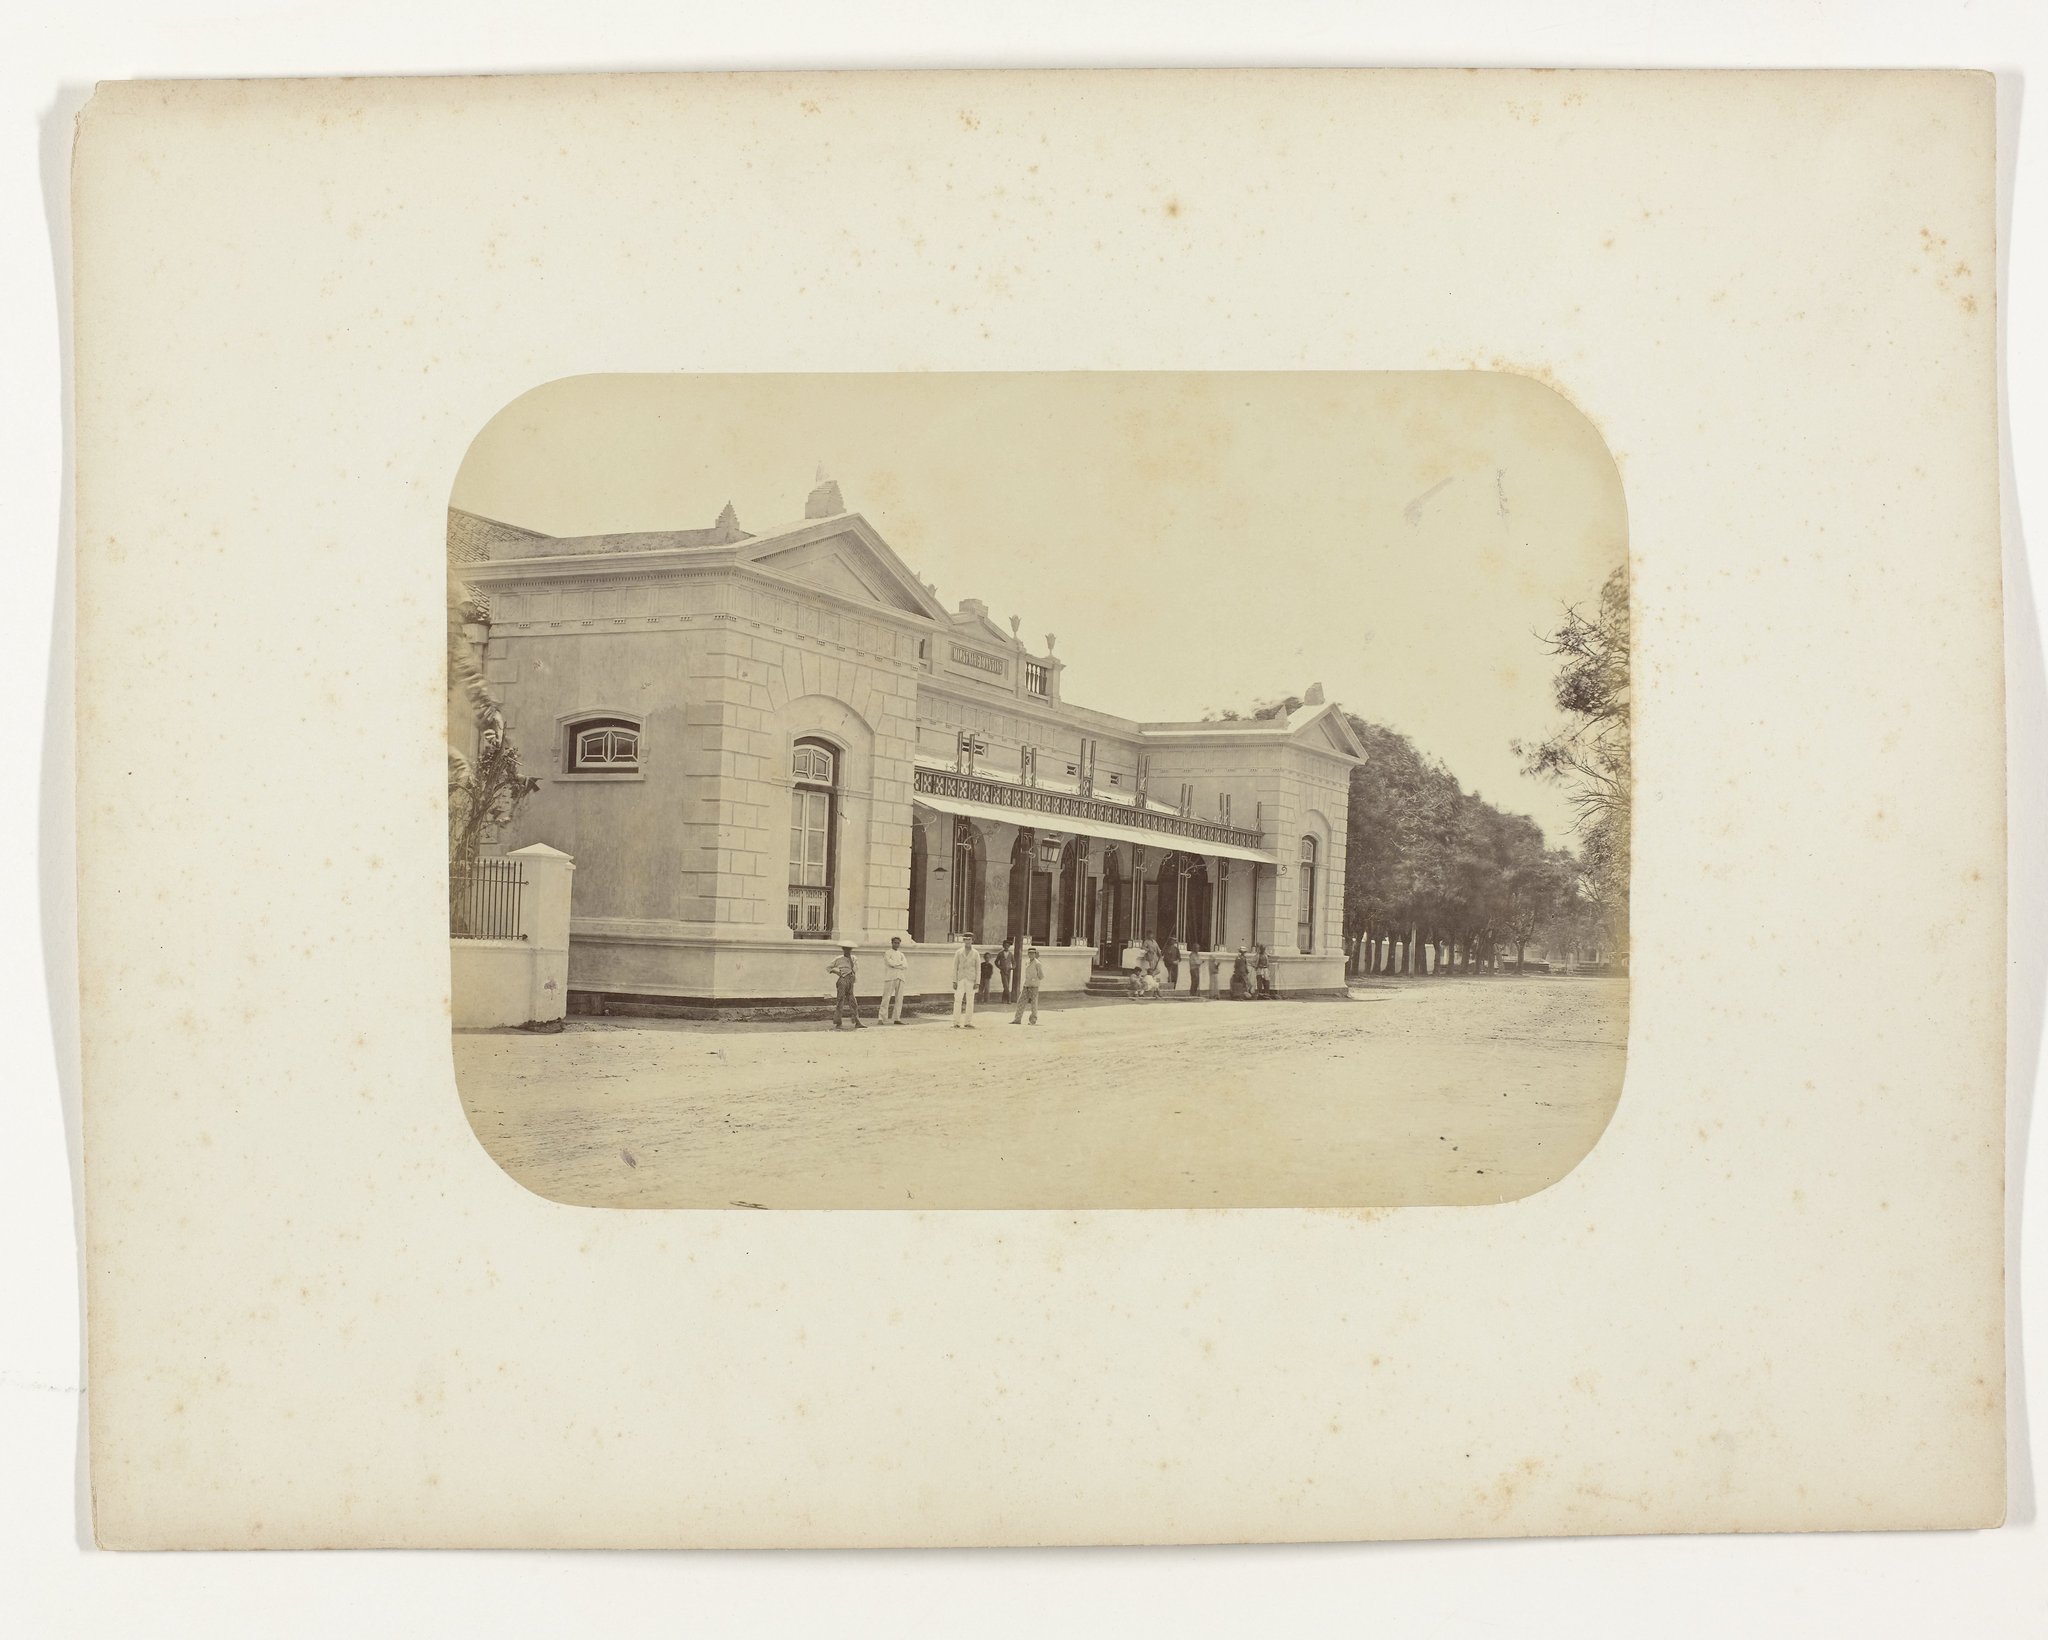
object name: photograph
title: De sociëteit van Surabaya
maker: herman salzwedel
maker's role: fotograaf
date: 1876-1884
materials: photographic support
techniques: albumen print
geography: surabaya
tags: utrecht, the hague, colonial system, club, meeting place, surabaya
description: De sociëteit van Surabaya met op het huis het opschrift militaire kantine. Voor het gebouw staan enkele inlanders. Onderdeel van het fotoalbum door de Soerabayasche Vereeniging van Suikerfabrikanten aangeboden aan Frederik Beyerinck, resident van Soerabaja.